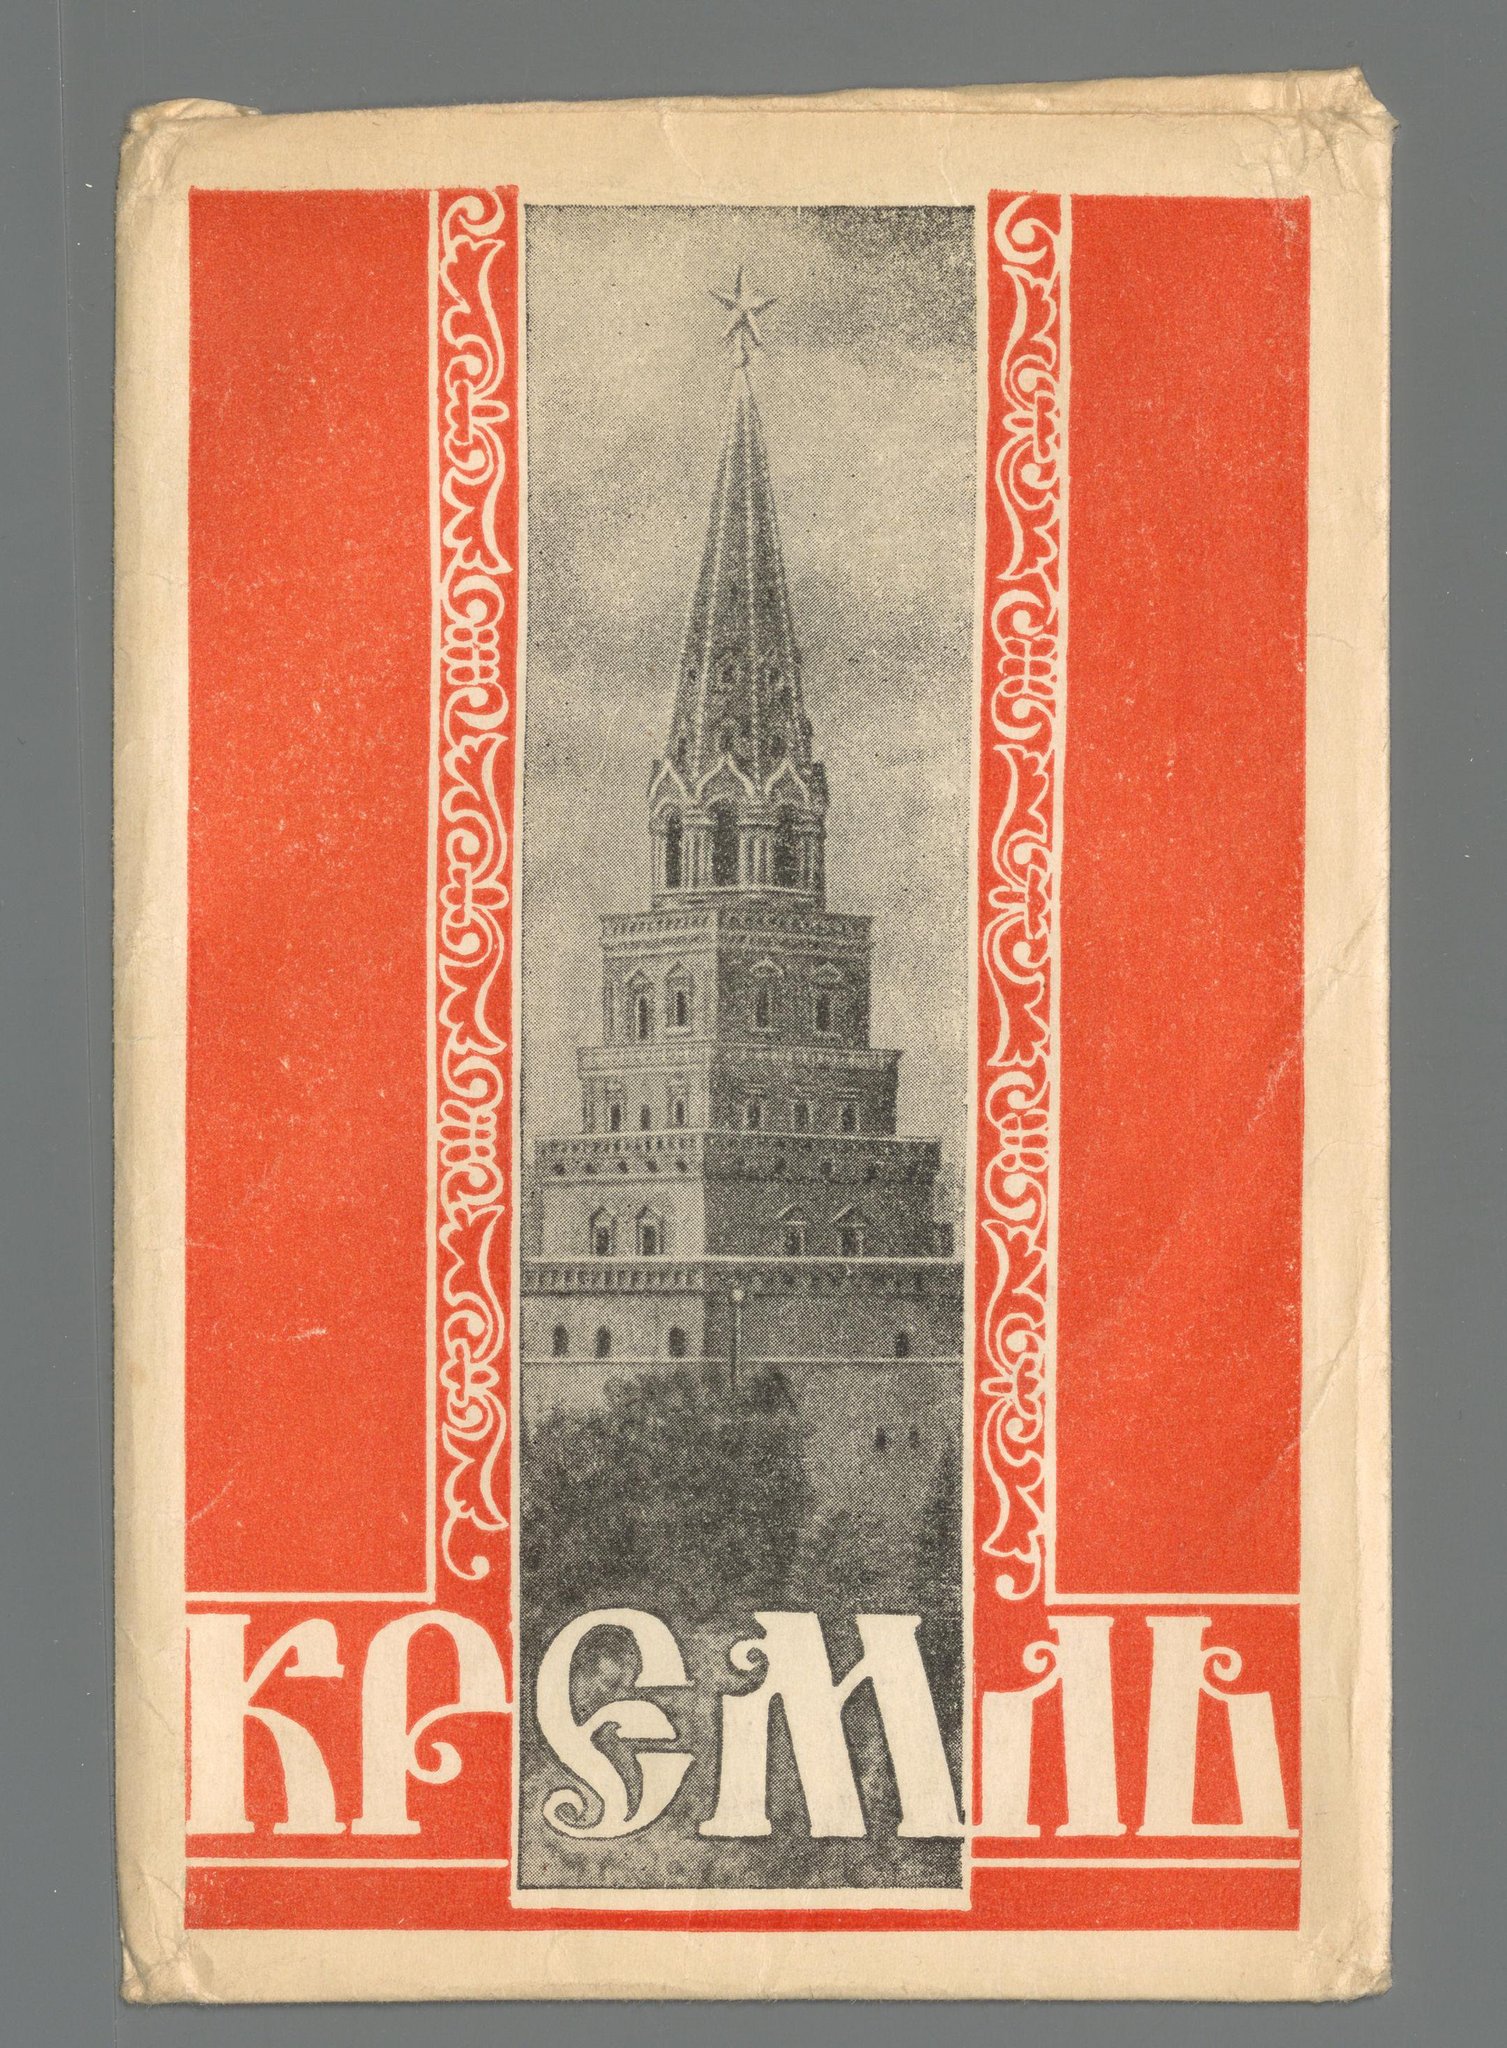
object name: wrapper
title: Omslag voor twintig fotobriefkaarten met gezichten van het Kremlin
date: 1954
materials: cardboard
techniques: lithograph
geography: moscow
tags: fortress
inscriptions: date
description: De titel op object staat in het Russisch.